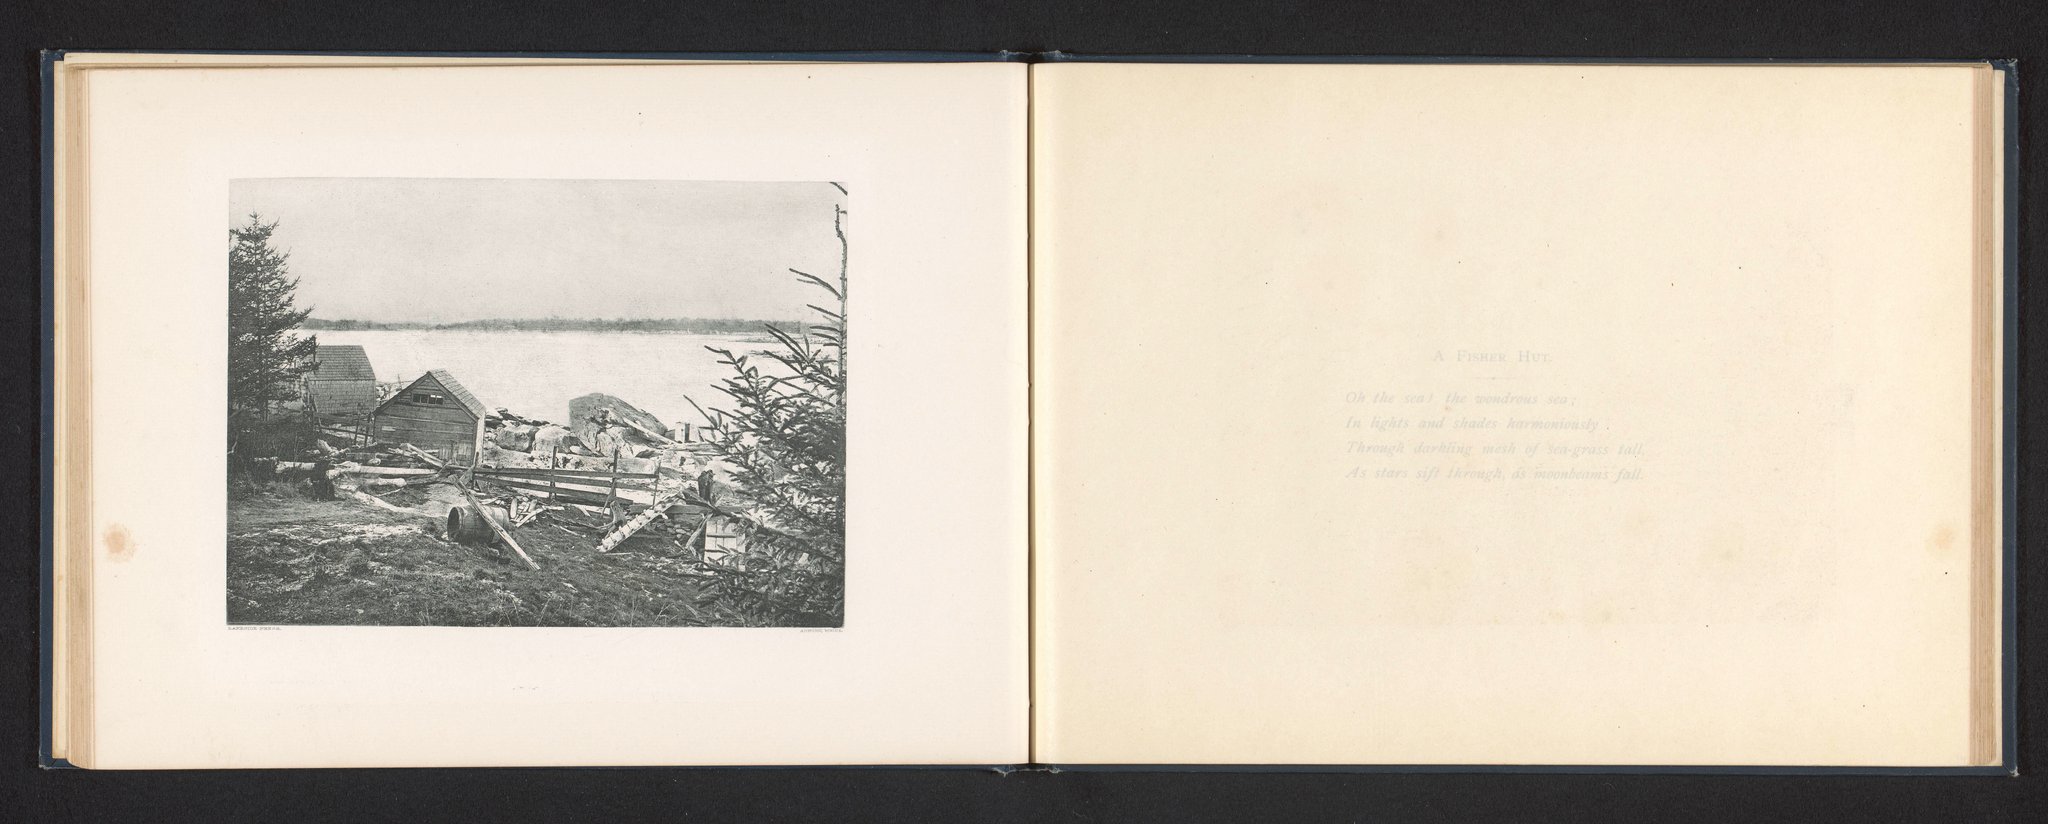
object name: page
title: Gezicht op een huis van een visser op de kust van Maine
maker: Anonymous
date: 1880-1890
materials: paper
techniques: photoaquatint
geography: maine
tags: hut, cabin, lodge, coast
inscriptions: inscription: ‘A Fisher Hut. (...)’